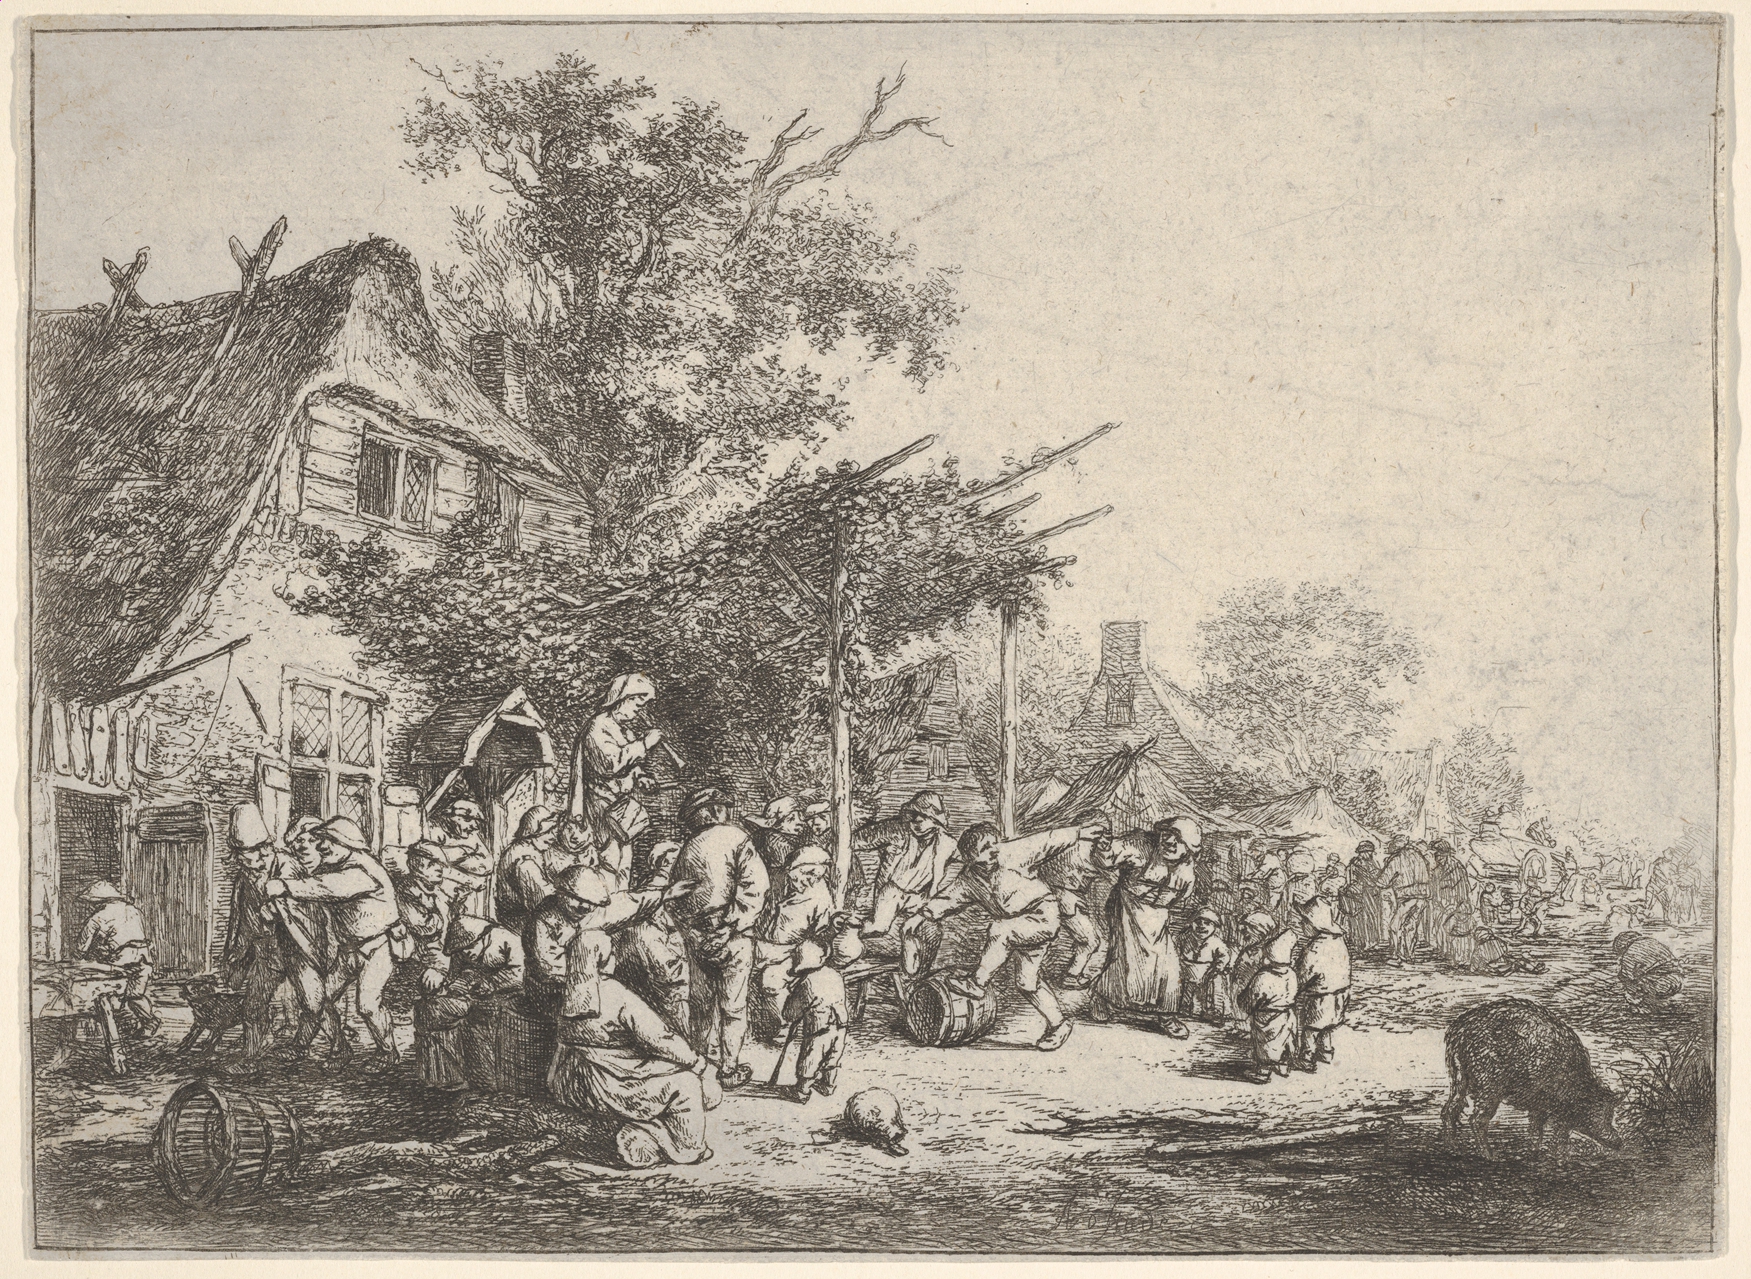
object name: print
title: A group of figures dancing under a trellis attached to a house, a standing figure carrying a drum and holding a horn to his mouth, surrounded by onlookers, a lane with houses and carriages beyond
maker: adriaen van ostade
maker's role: artist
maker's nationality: dutch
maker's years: 1610-1685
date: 1650-1655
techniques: etching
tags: houses,dancing,horns,crowd